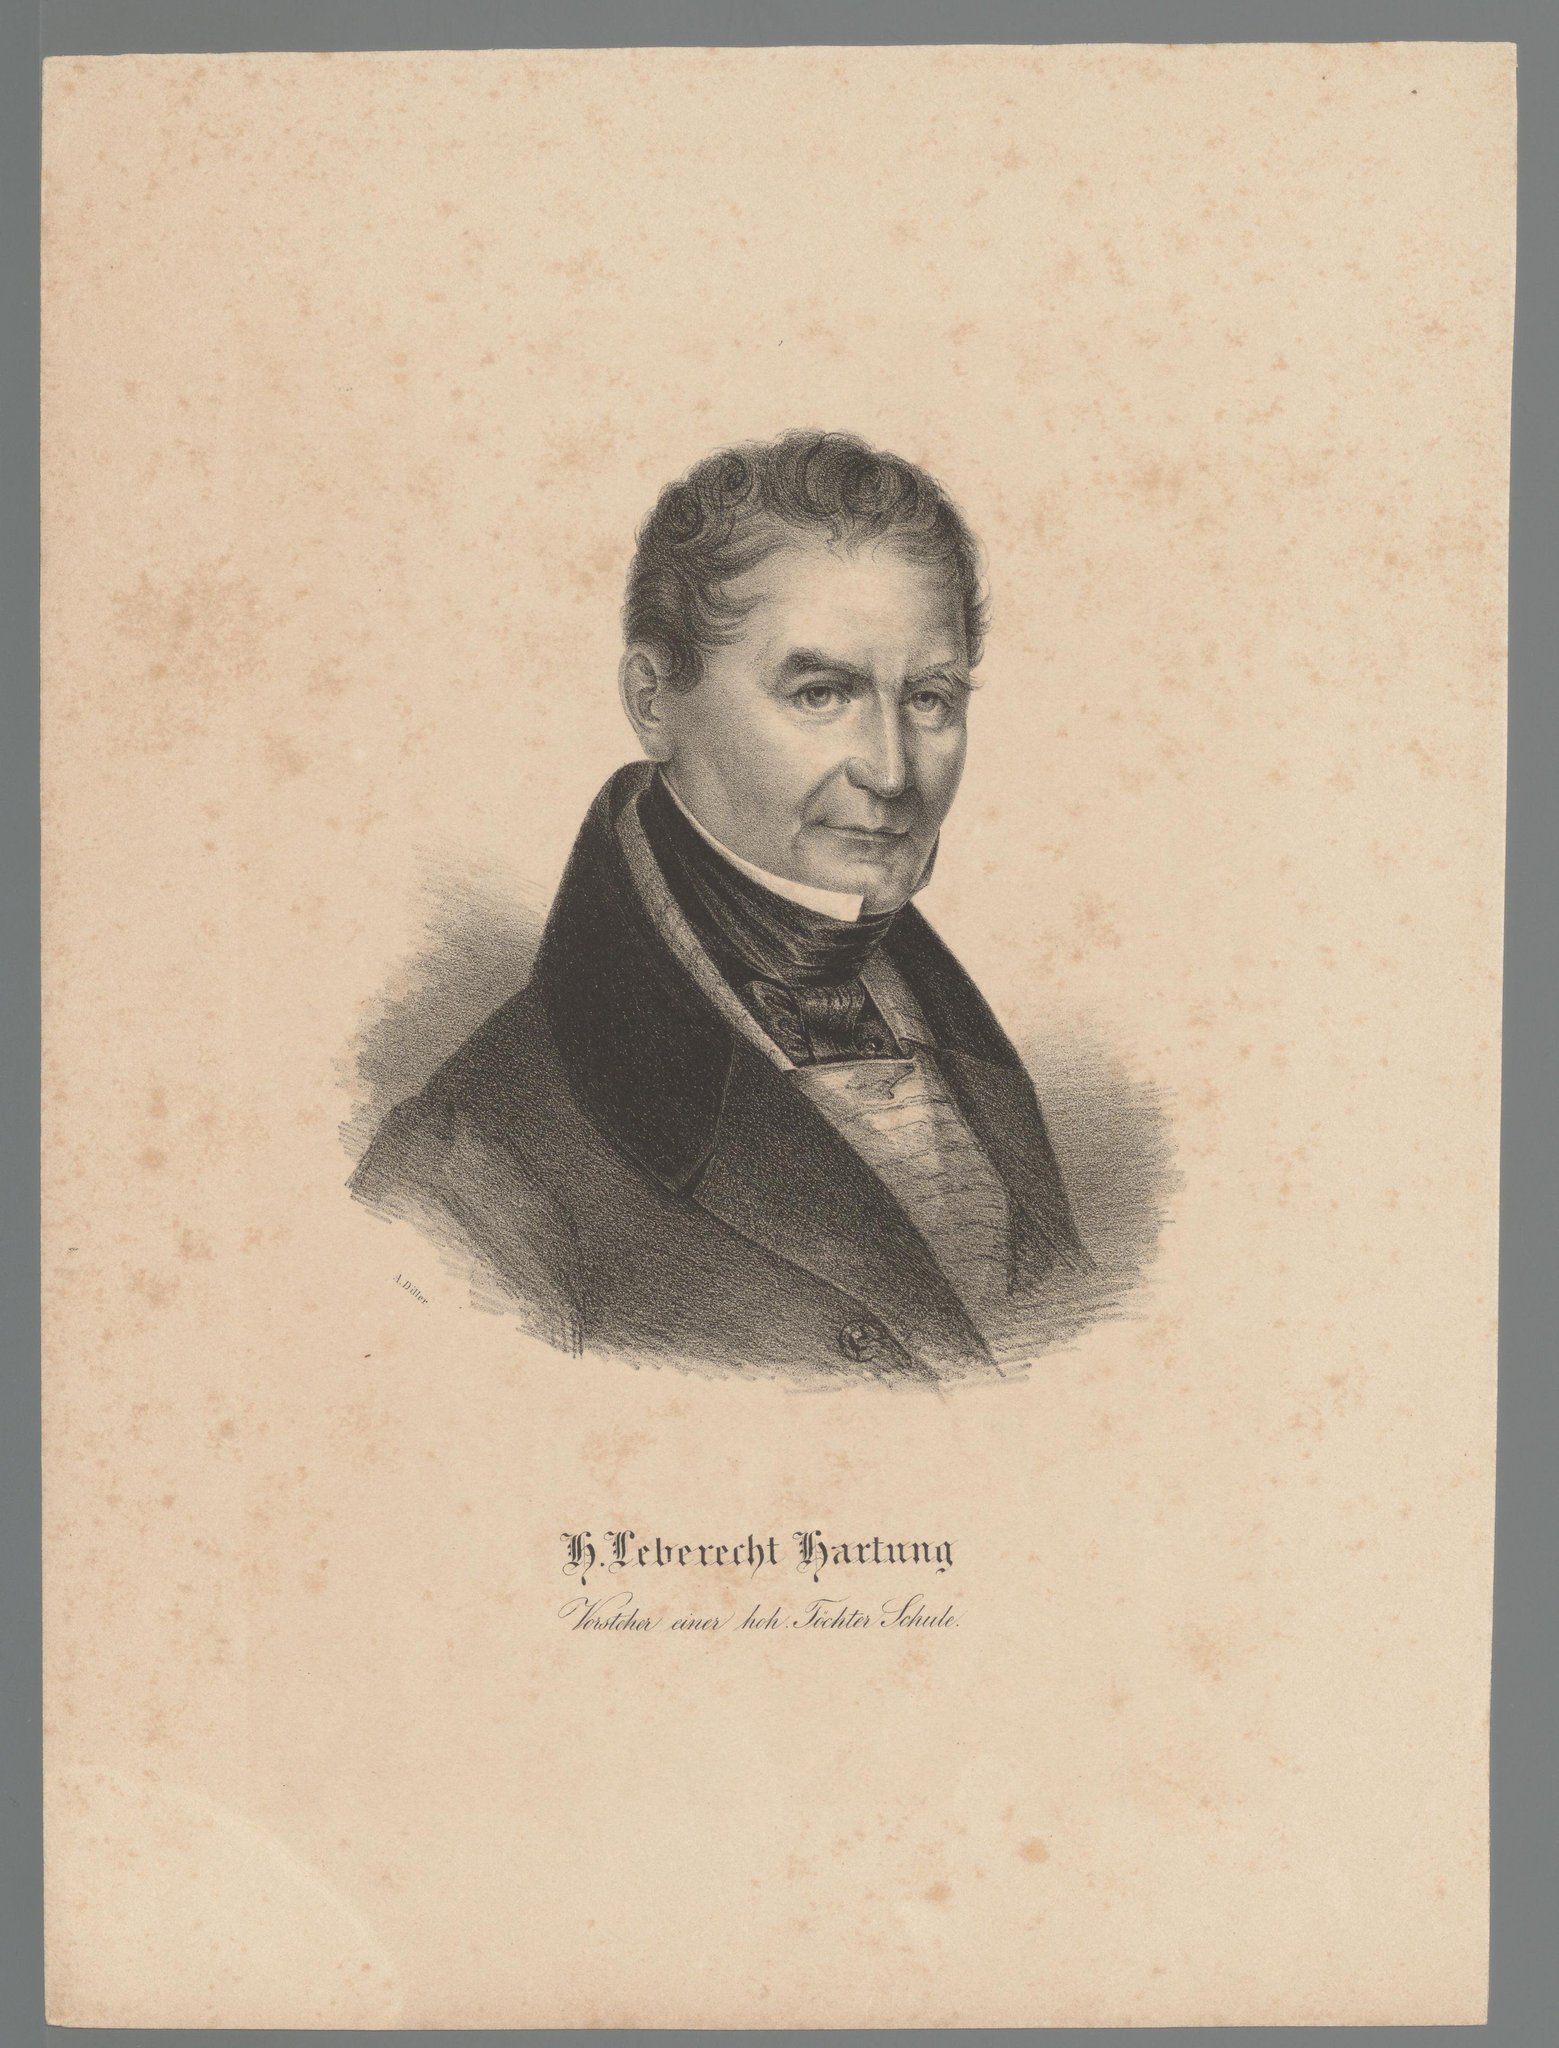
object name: print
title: H. Leberecht Hartung, Vorsteher einer hoh. Töchter Schule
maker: a. diller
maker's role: print maker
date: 1820-1850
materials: paper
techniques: lithograph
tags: adult man, historical persons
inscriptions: collector's mark: Lugt 2228